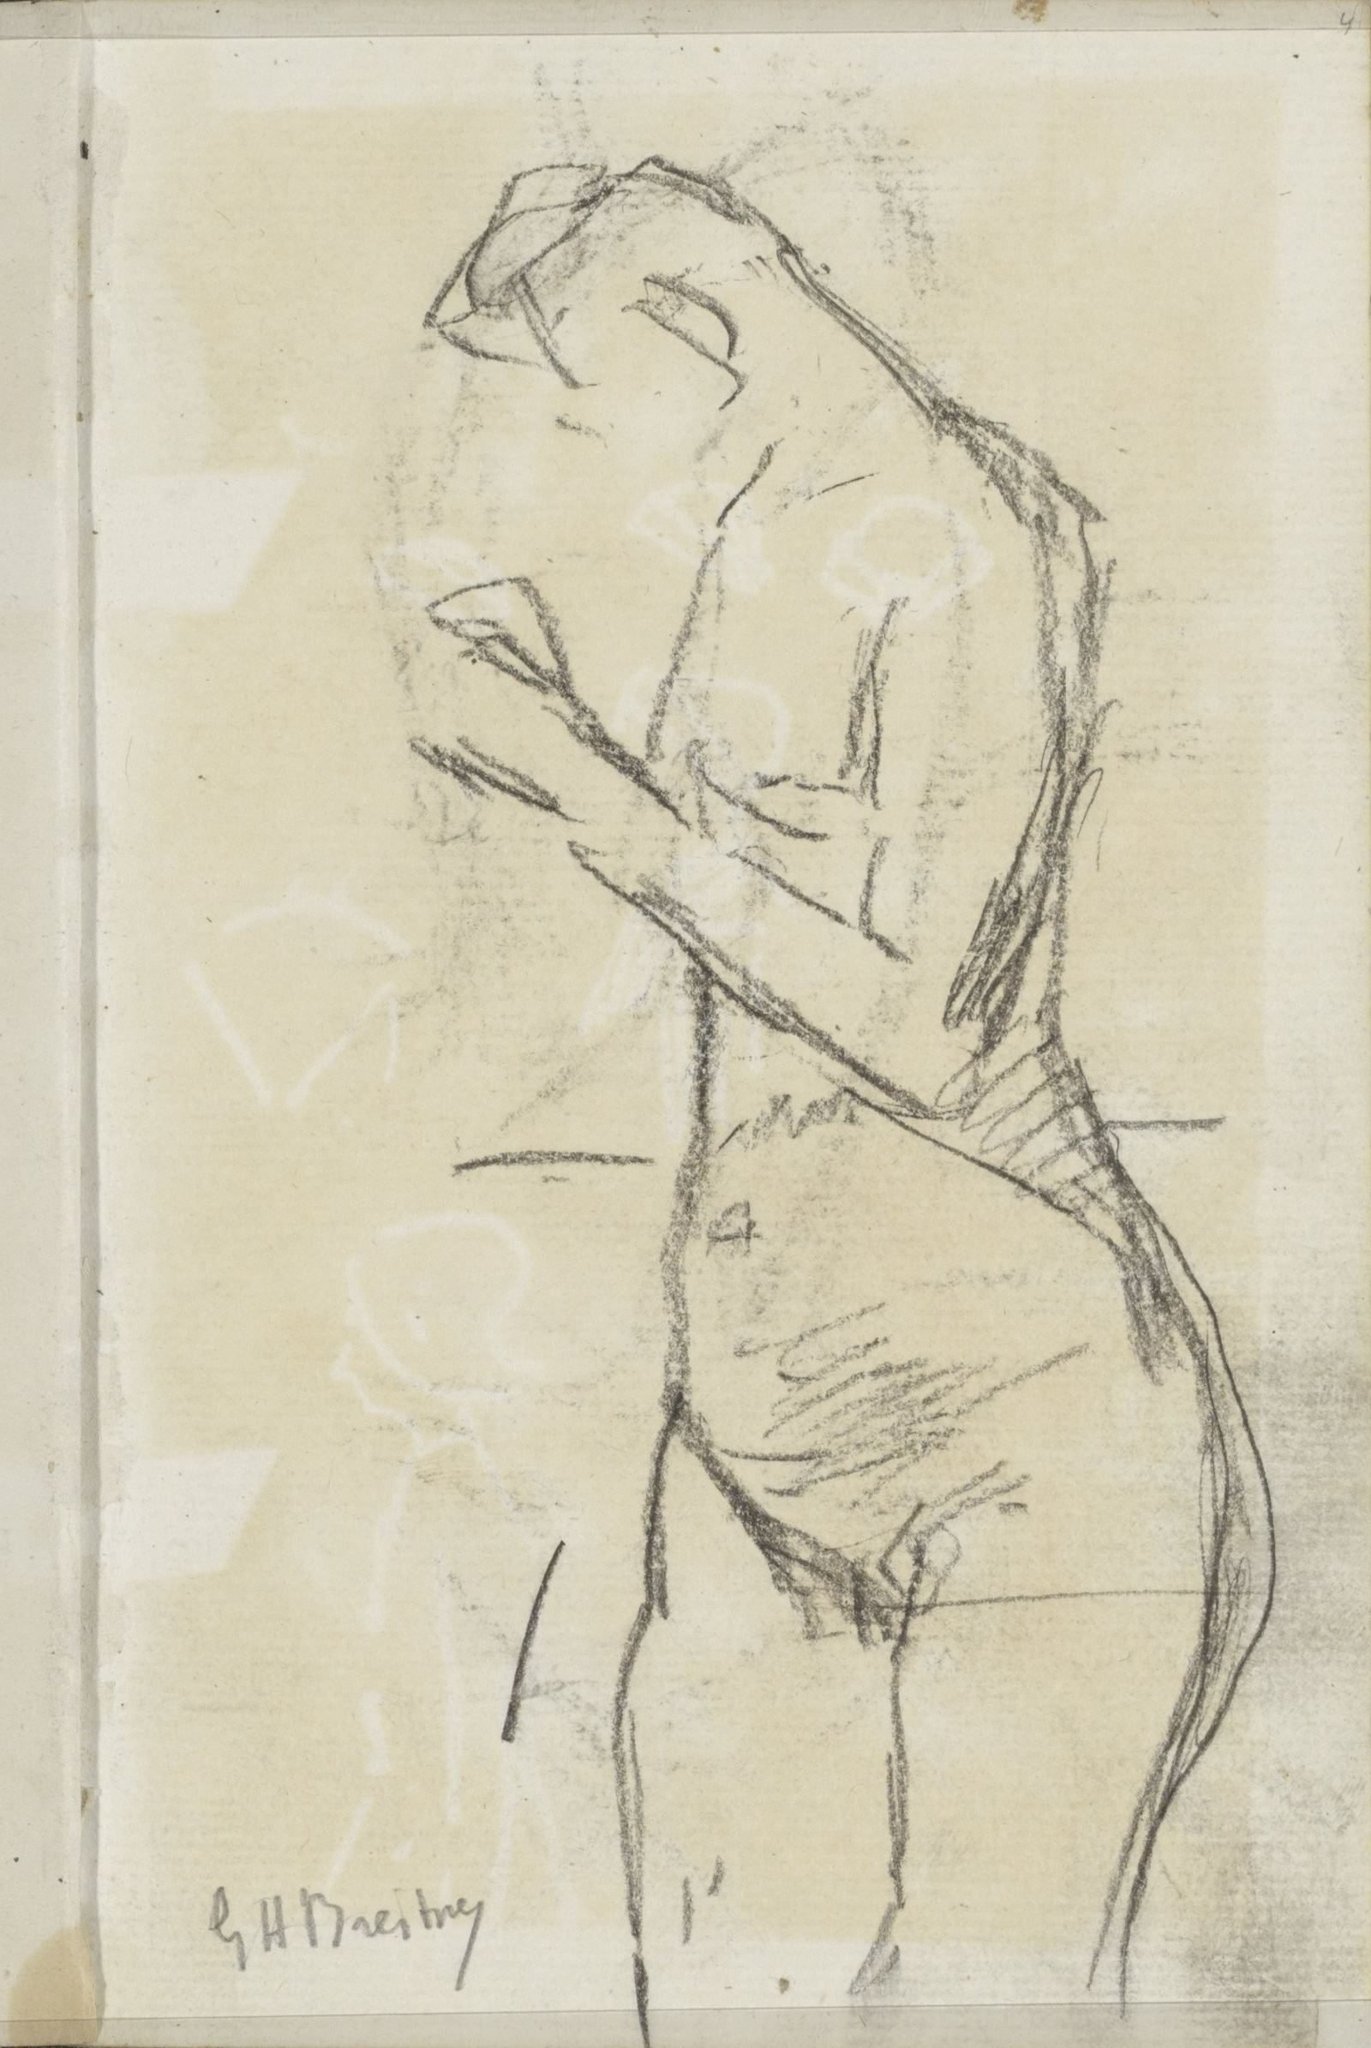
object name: sketchbook leaf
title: Standing Female Nude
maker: george hendrik breitner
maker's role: draughtsman, painter, print maker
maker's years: 1857-1923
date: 1892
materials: chalk, paper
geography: amsterdam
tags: standing figure - aa - female human figure (+ nude human being)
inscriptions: signature: ‘G.H. Breitner’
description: Pagina 4 uit een schetsboek met 20 bladen.